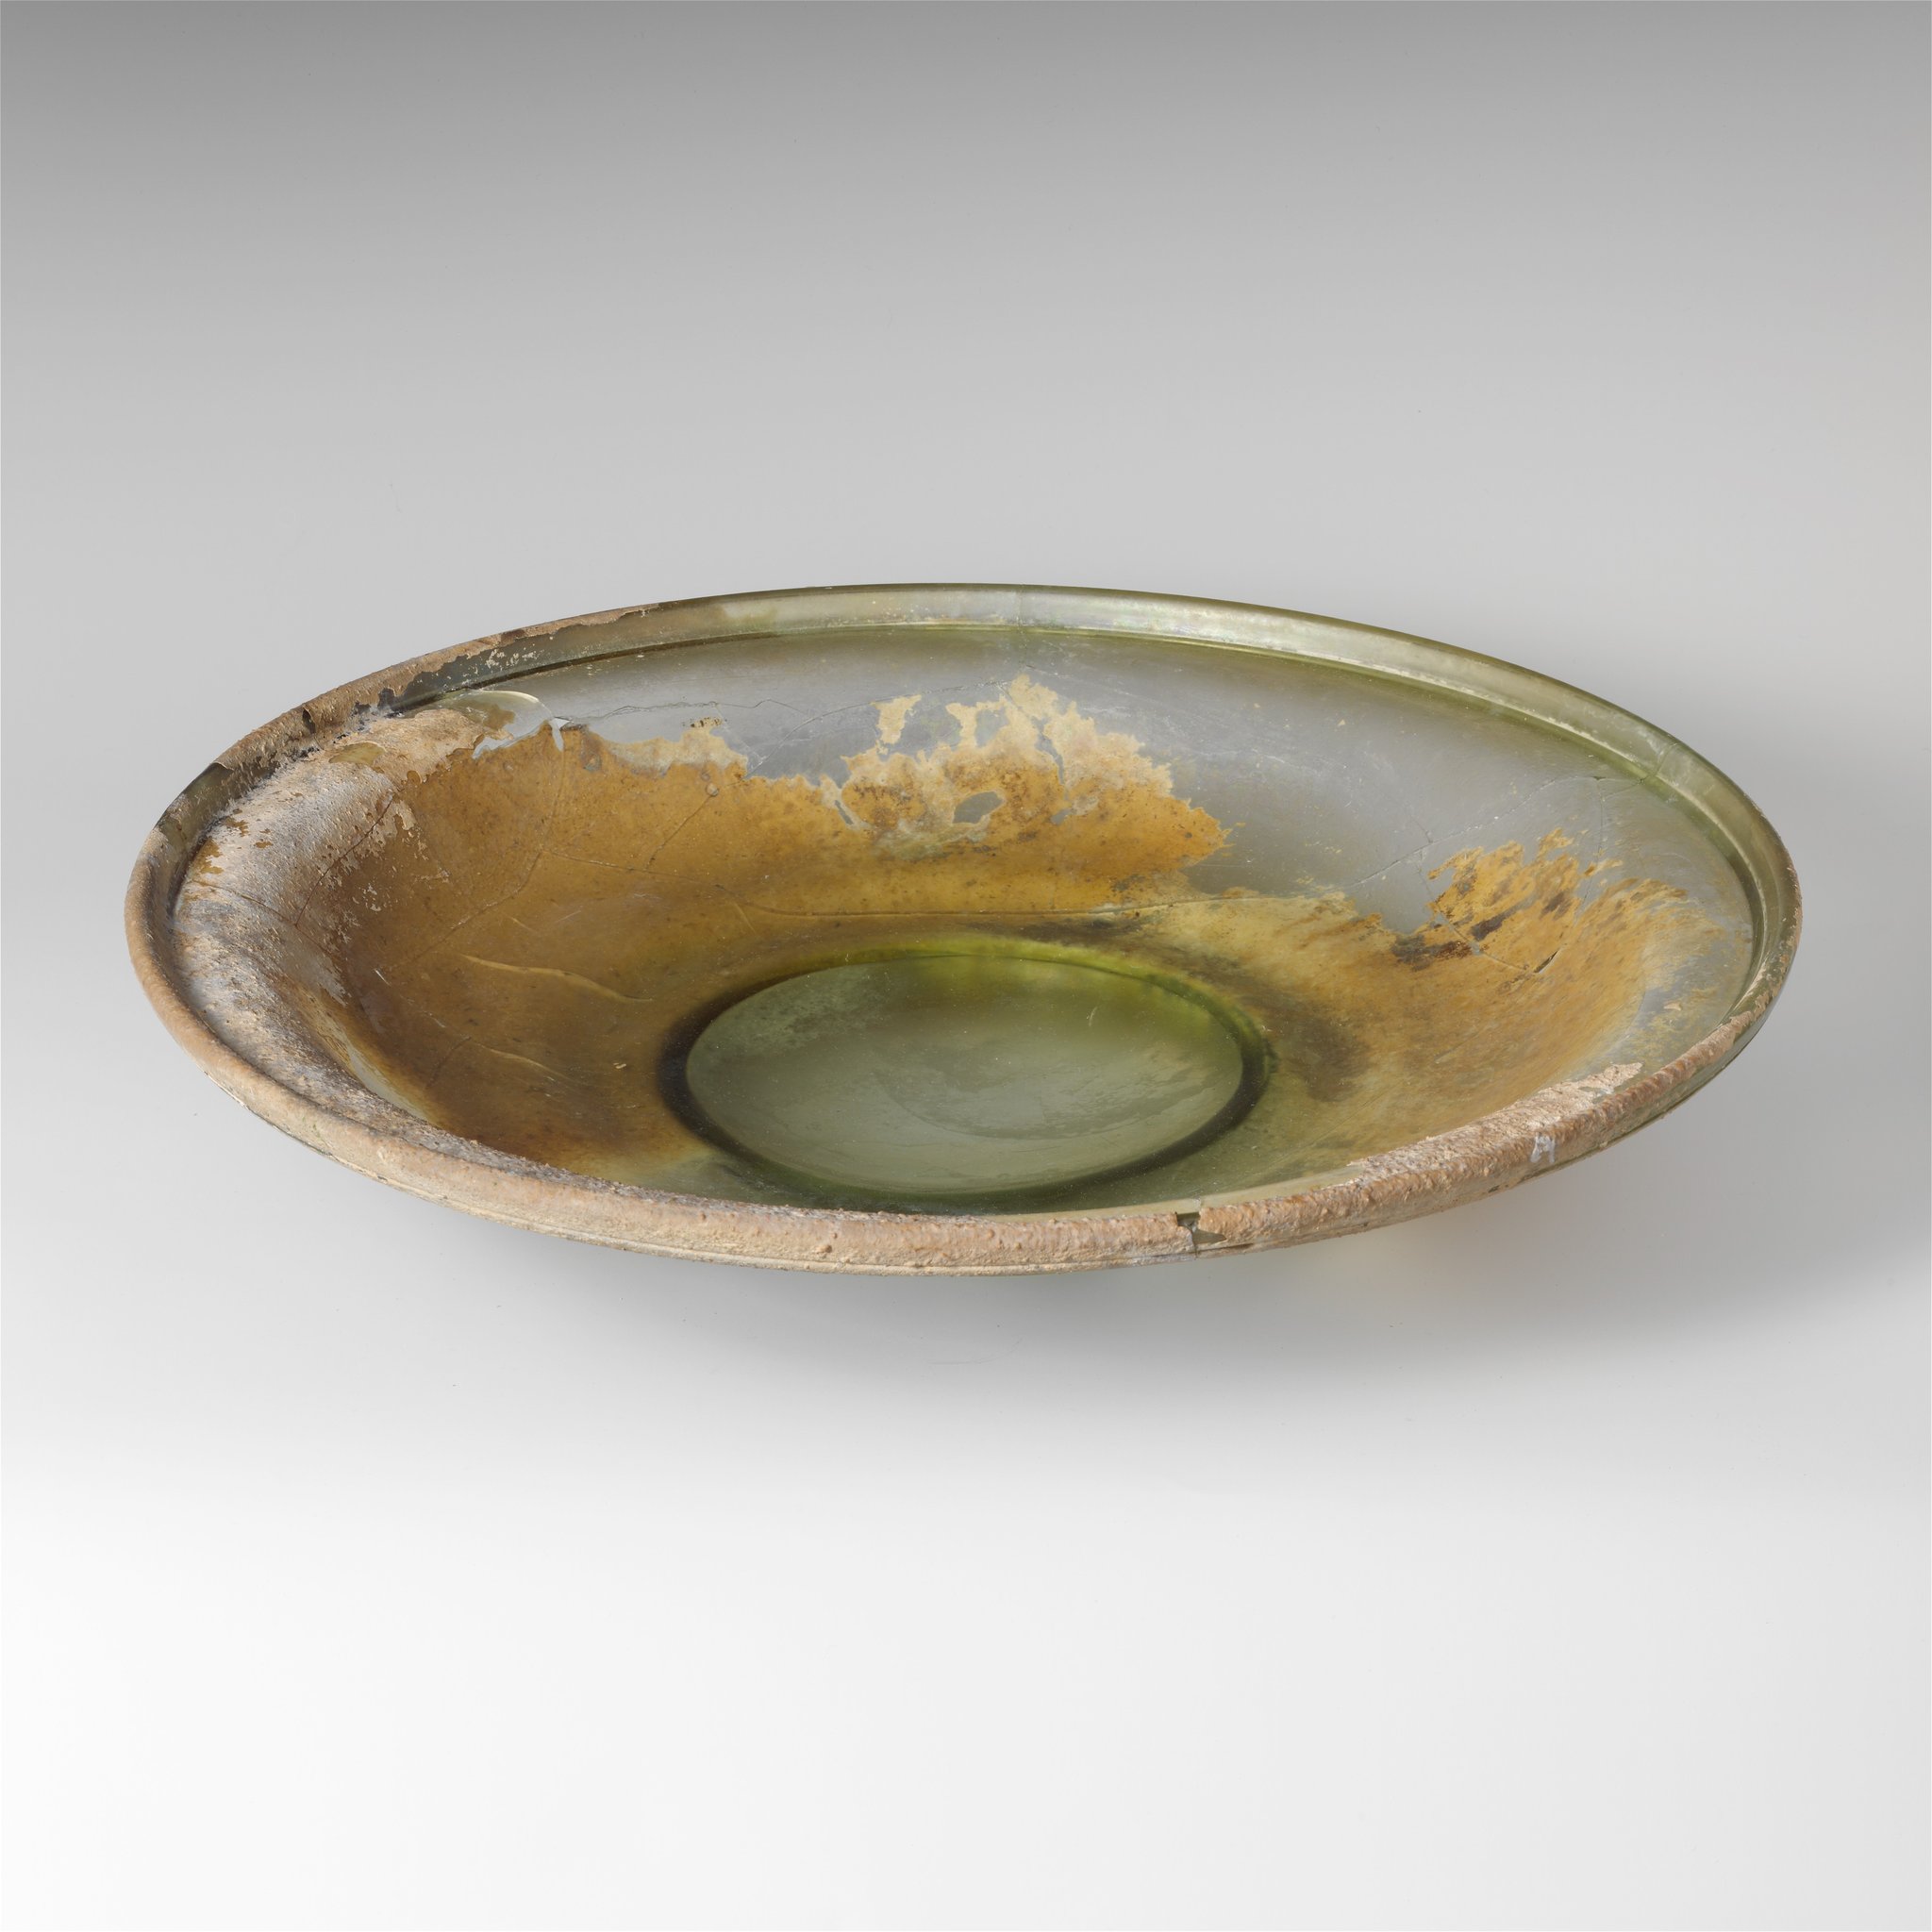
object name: dish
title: Glass dish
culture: roman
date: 301-400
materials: glass